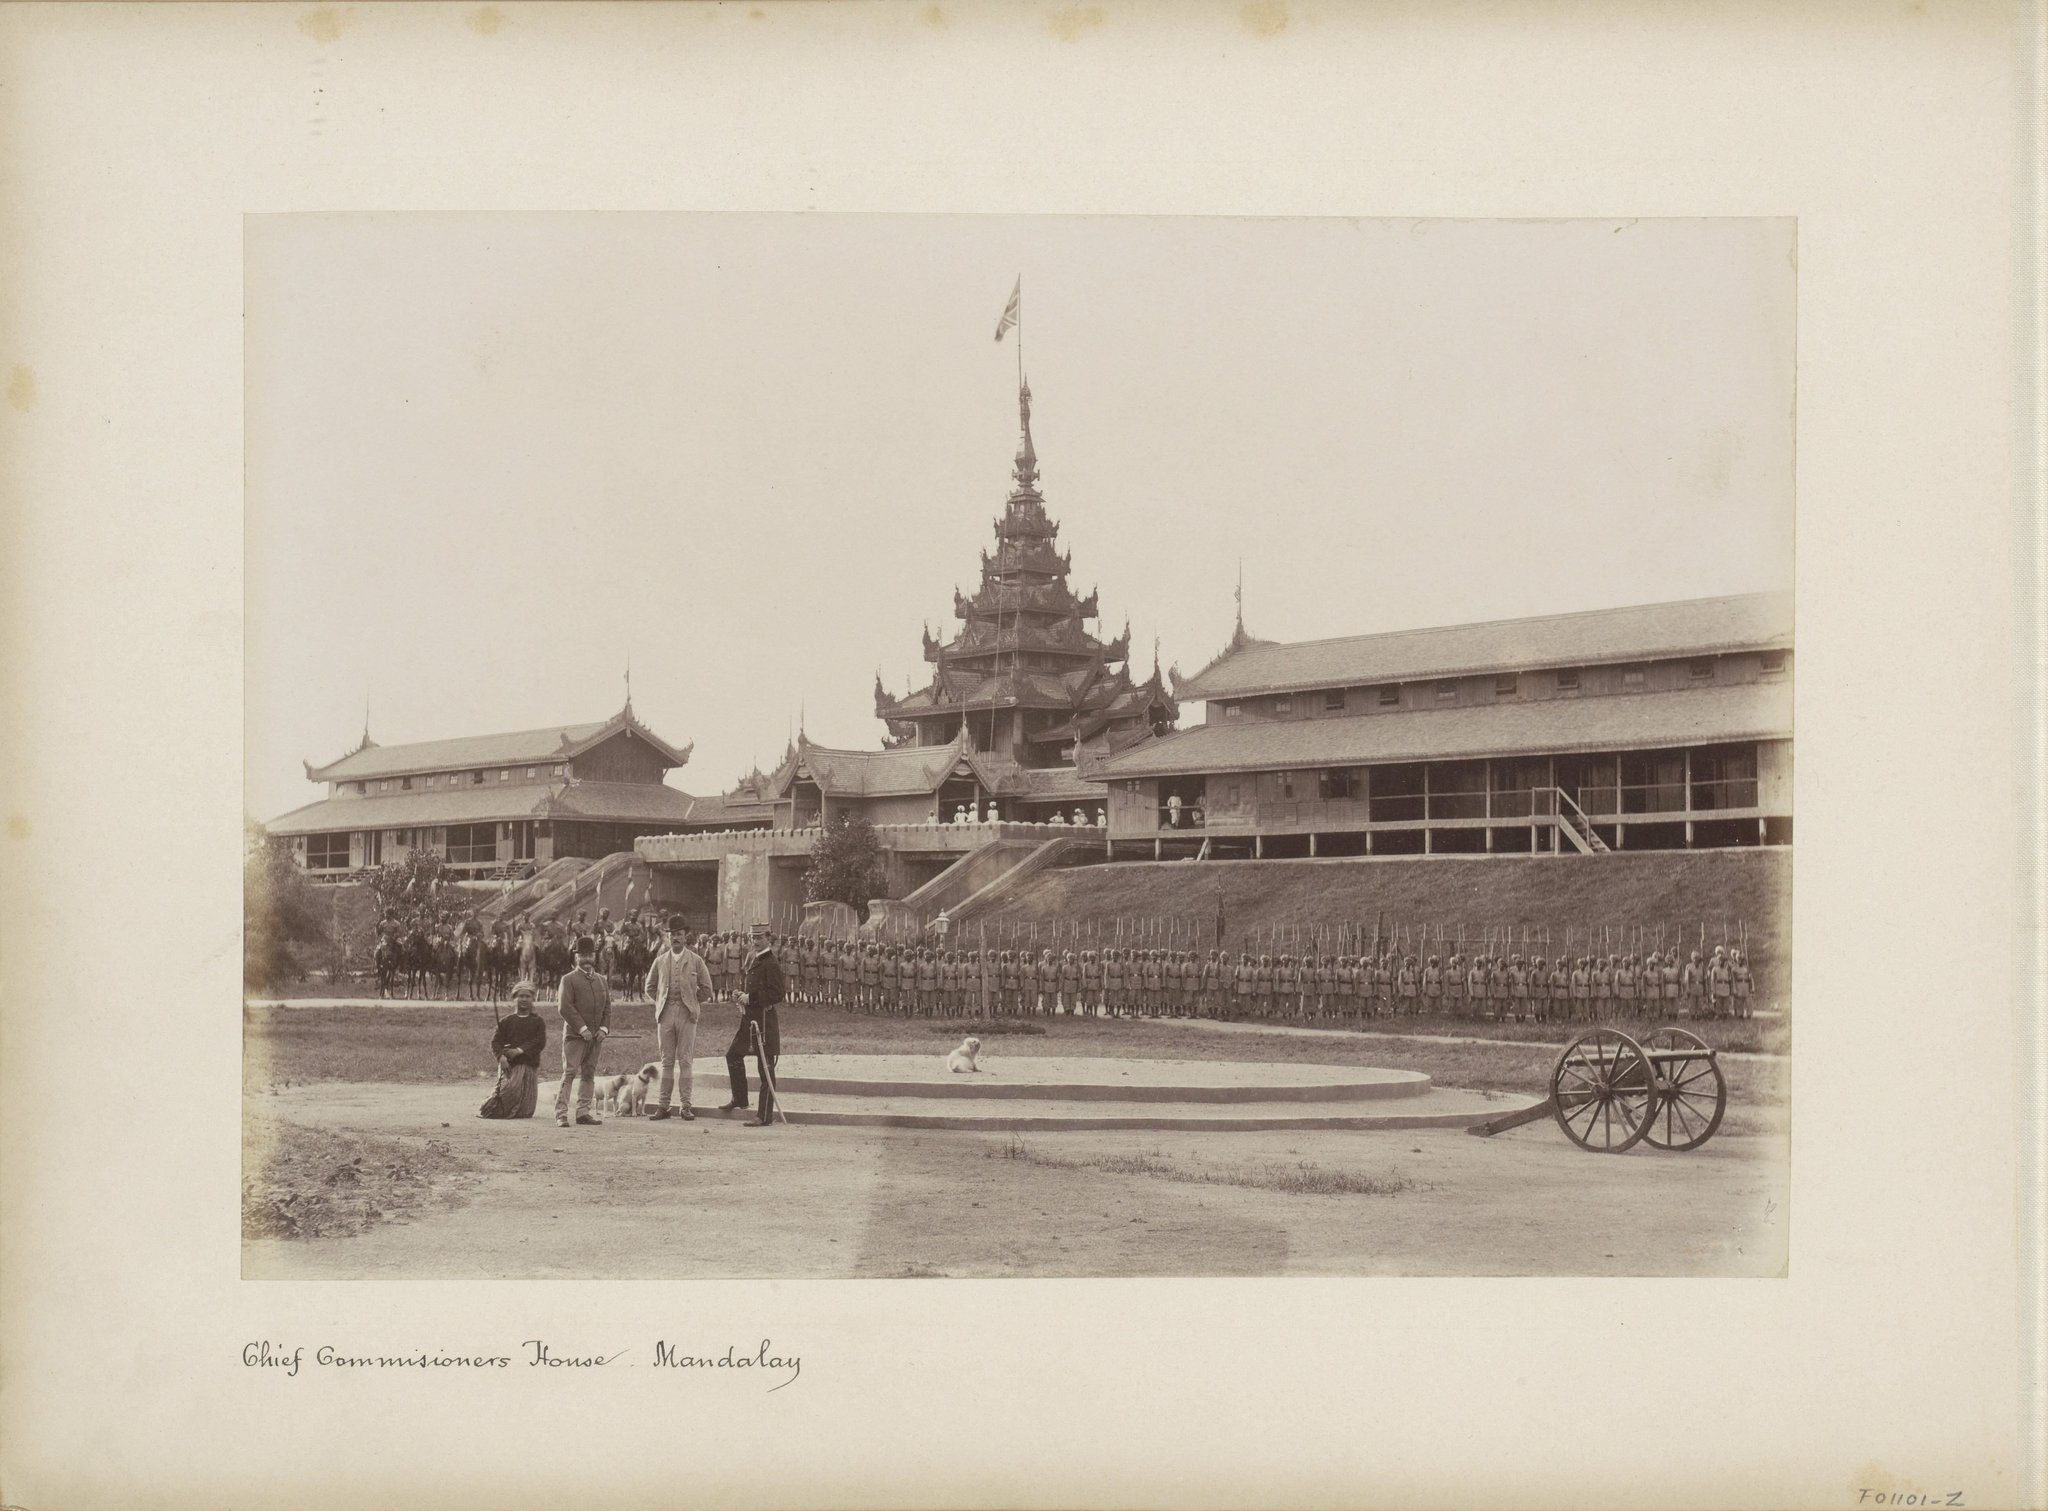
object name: album leaf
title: Military officials (possibly British) at the Chief Commissioner's House, Mandalay, Myanmar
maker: Anonymous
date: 1886-1890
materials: cardboard, paper, photographic support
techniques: albumen print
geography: mandalay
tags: land forces, palace, firearms: cannon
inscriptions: caption: ‘Chief Commissioners House. Mandalay’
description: Onderdeel van Reisalbum met foto's van bezienswaardigheden in Birma.